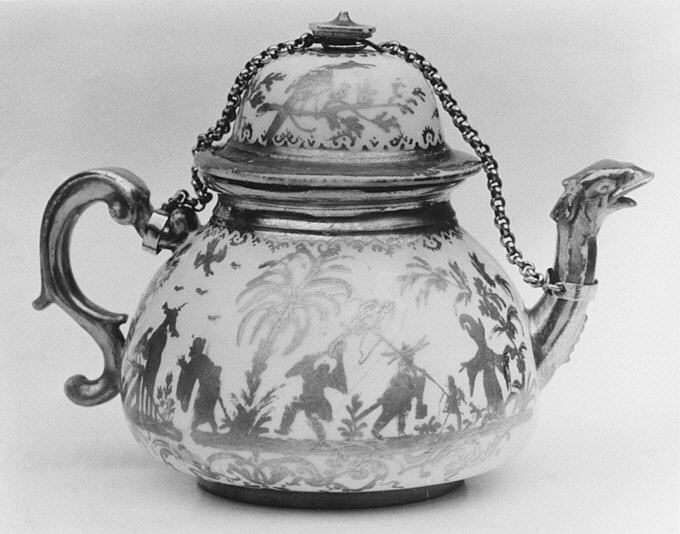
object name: teapot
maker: meissen manufactory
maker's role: manufactory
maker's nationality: german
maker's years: 1710-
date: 1720-1725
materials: hard paste porcelain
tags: human figures,birds,trees